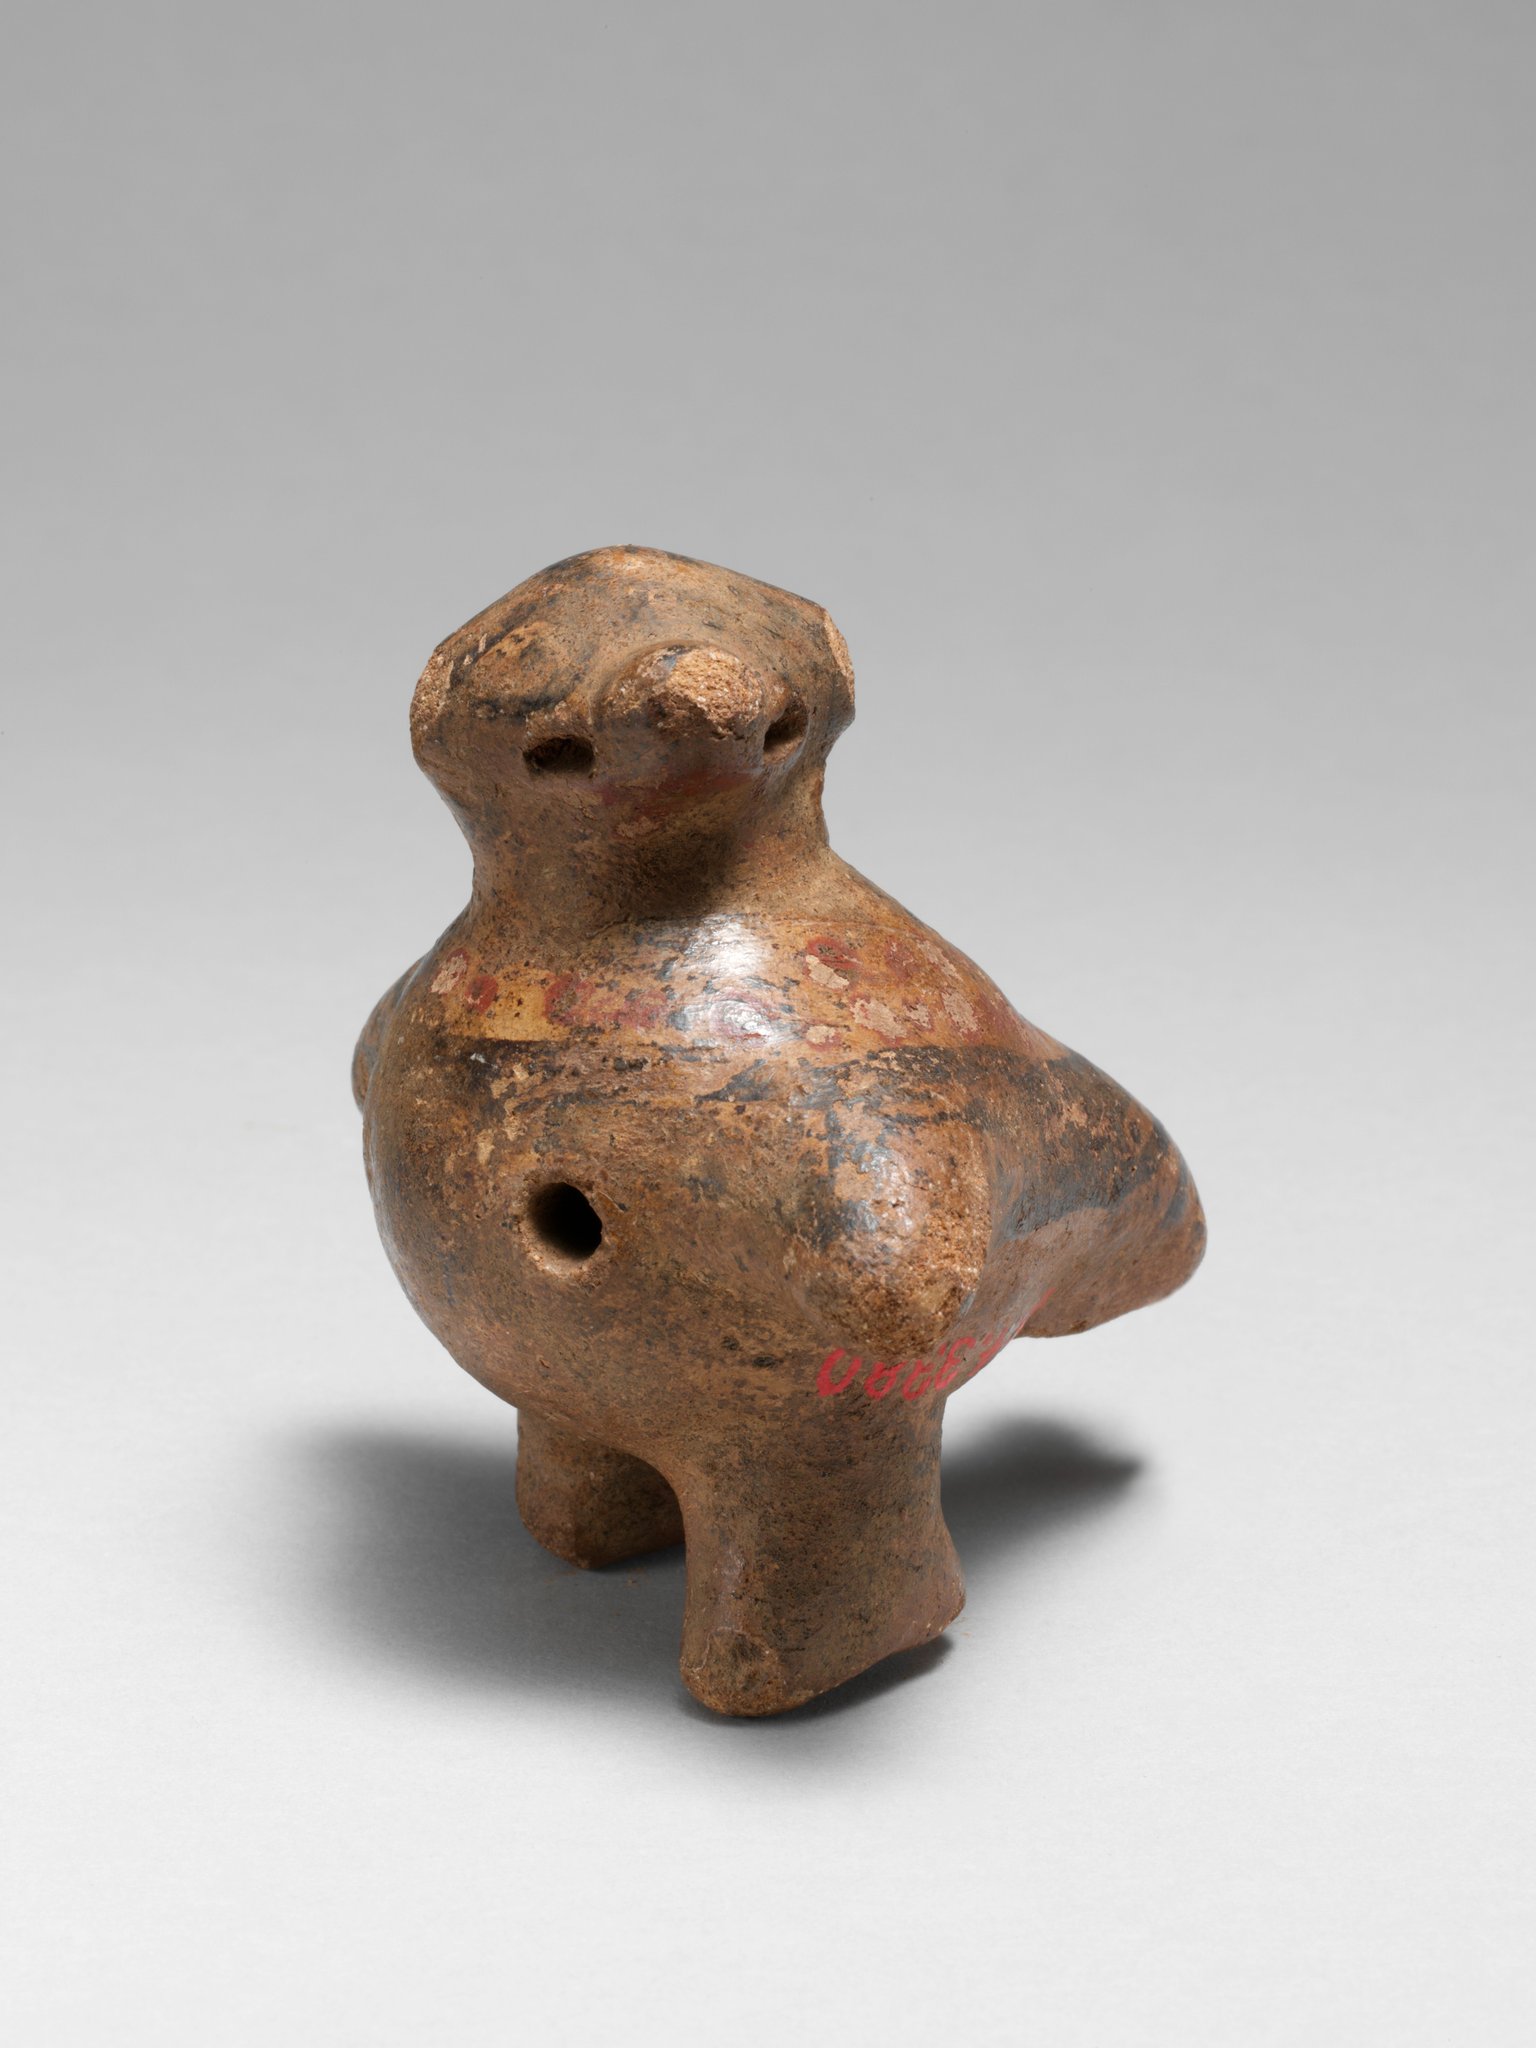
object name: pottery whistle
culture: costa rican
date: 800-1525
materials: clay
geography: costa rica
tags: birds